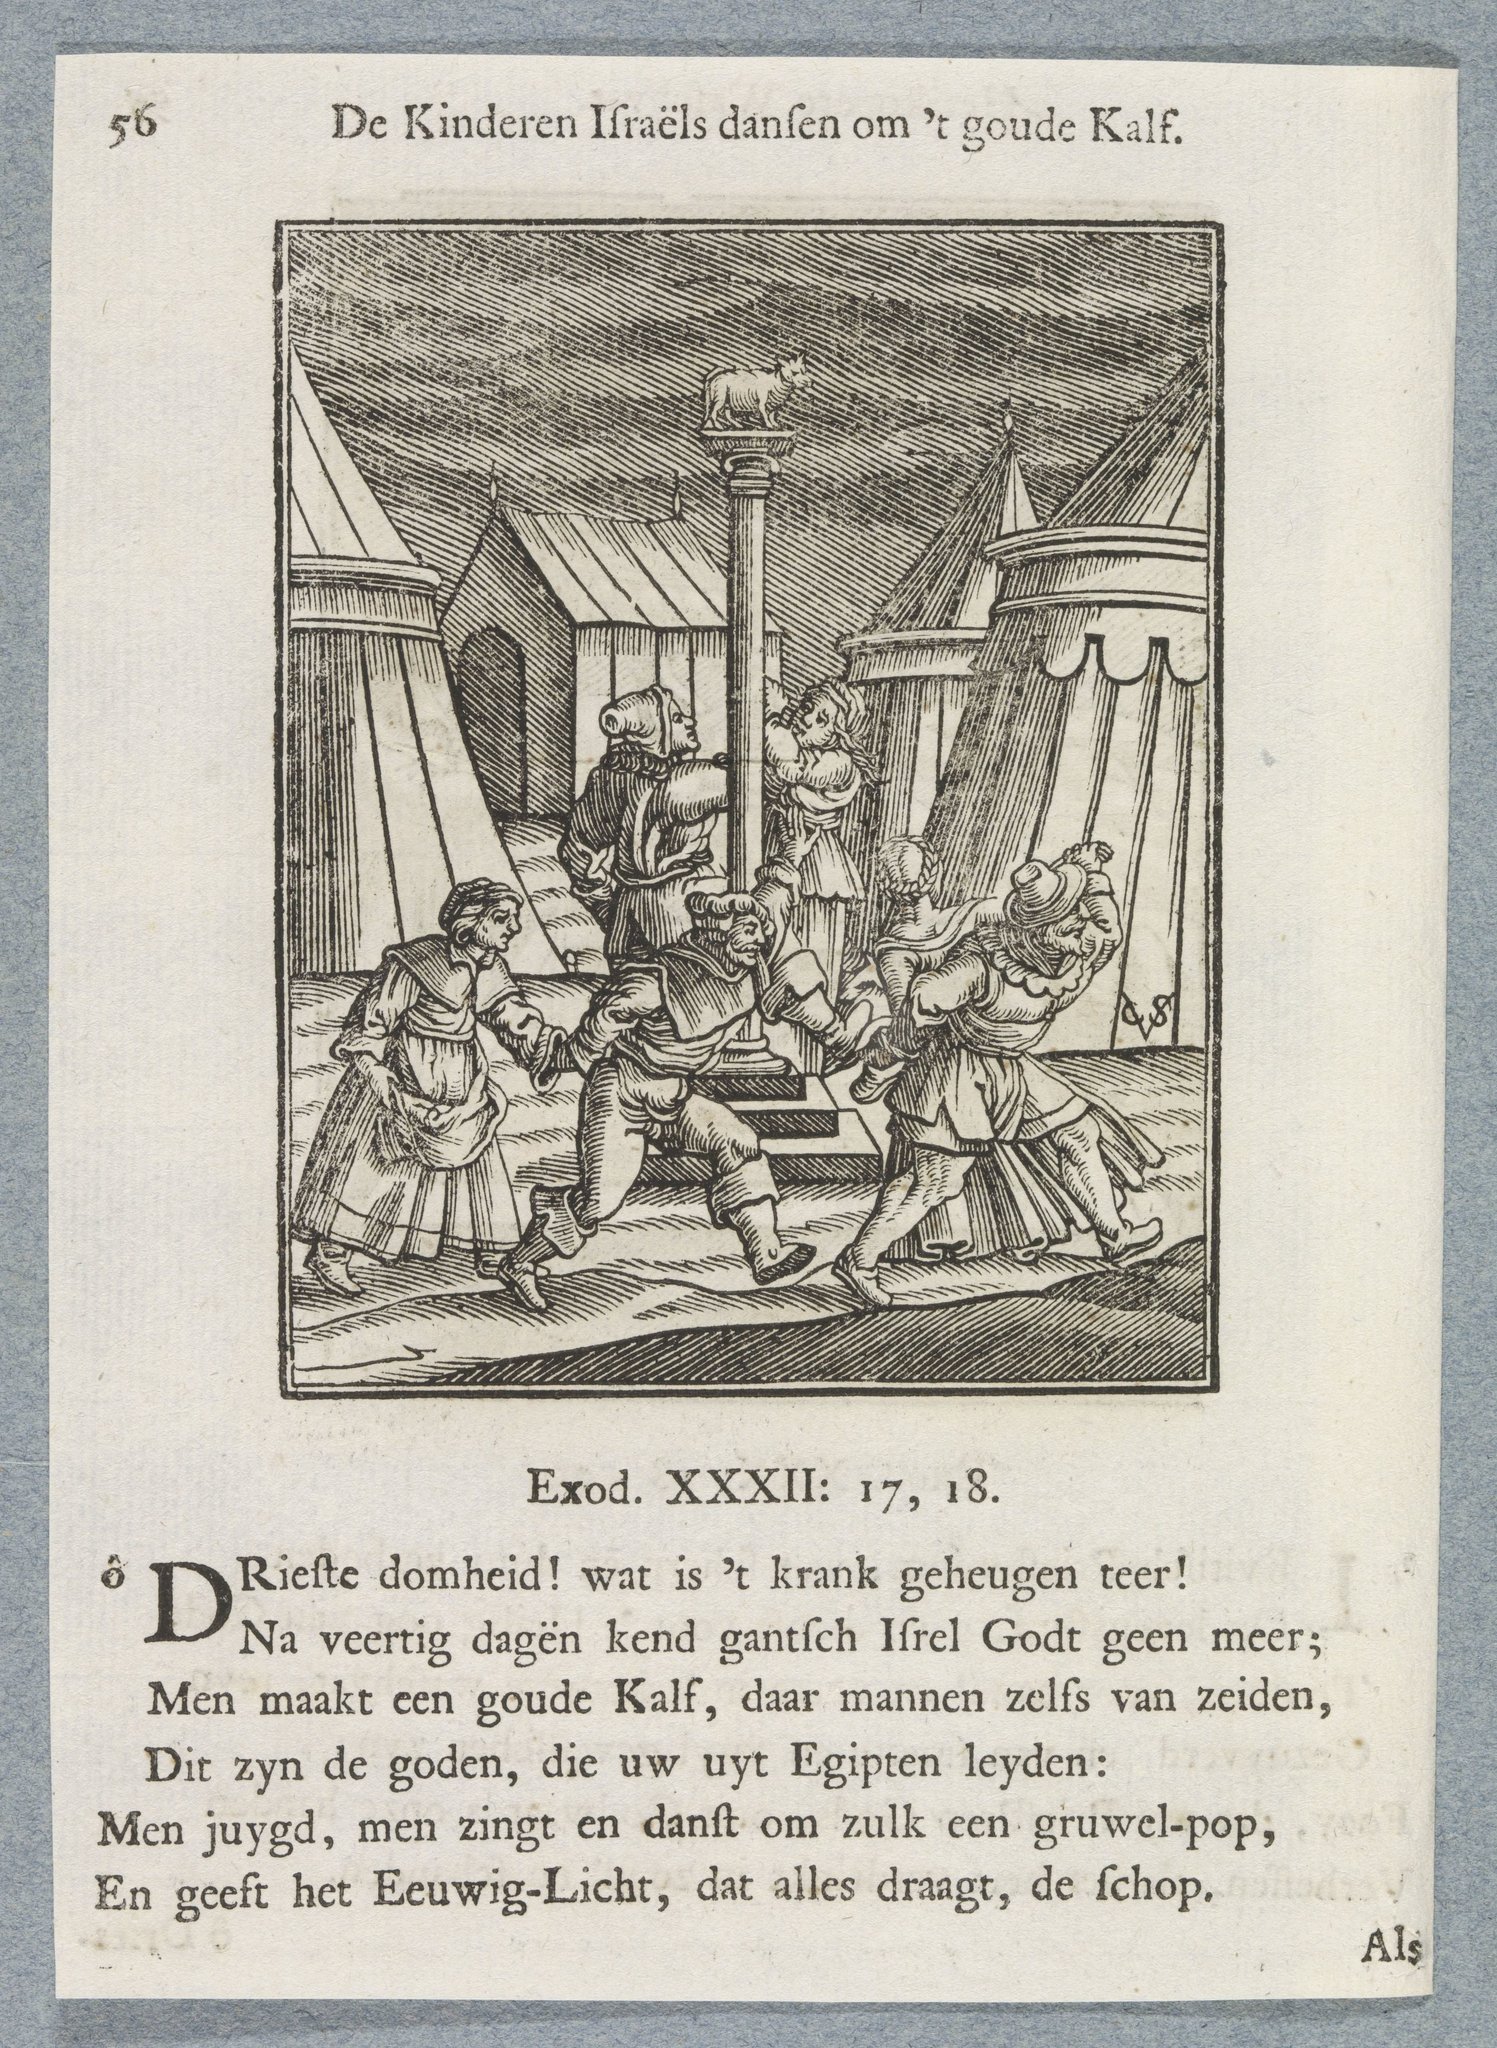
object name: book illustration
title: Dans rond het gouden kalf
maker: jan klooster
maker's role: bookseller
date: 1645-1646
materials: paper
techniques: letterpress printing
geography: amsterdam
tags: the people dance around the golden calf ~ exodus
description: De prent is afkomstig uit: Bybels Lusthof. Amsterdam, J. Klooster, 1740. De prent werd gemaakt voor de uitgaven van P.J. Paets uit Amsterdam. Ze komt in ieder geval voor in: Bibels Tresoor ofte der zielen lusthof. Amsterdam, P.J. Paets, 1646. Mogelijk staat ze ook in: Historien ende Prophetien. [Amsterdam], P.J. Paets, 1645.